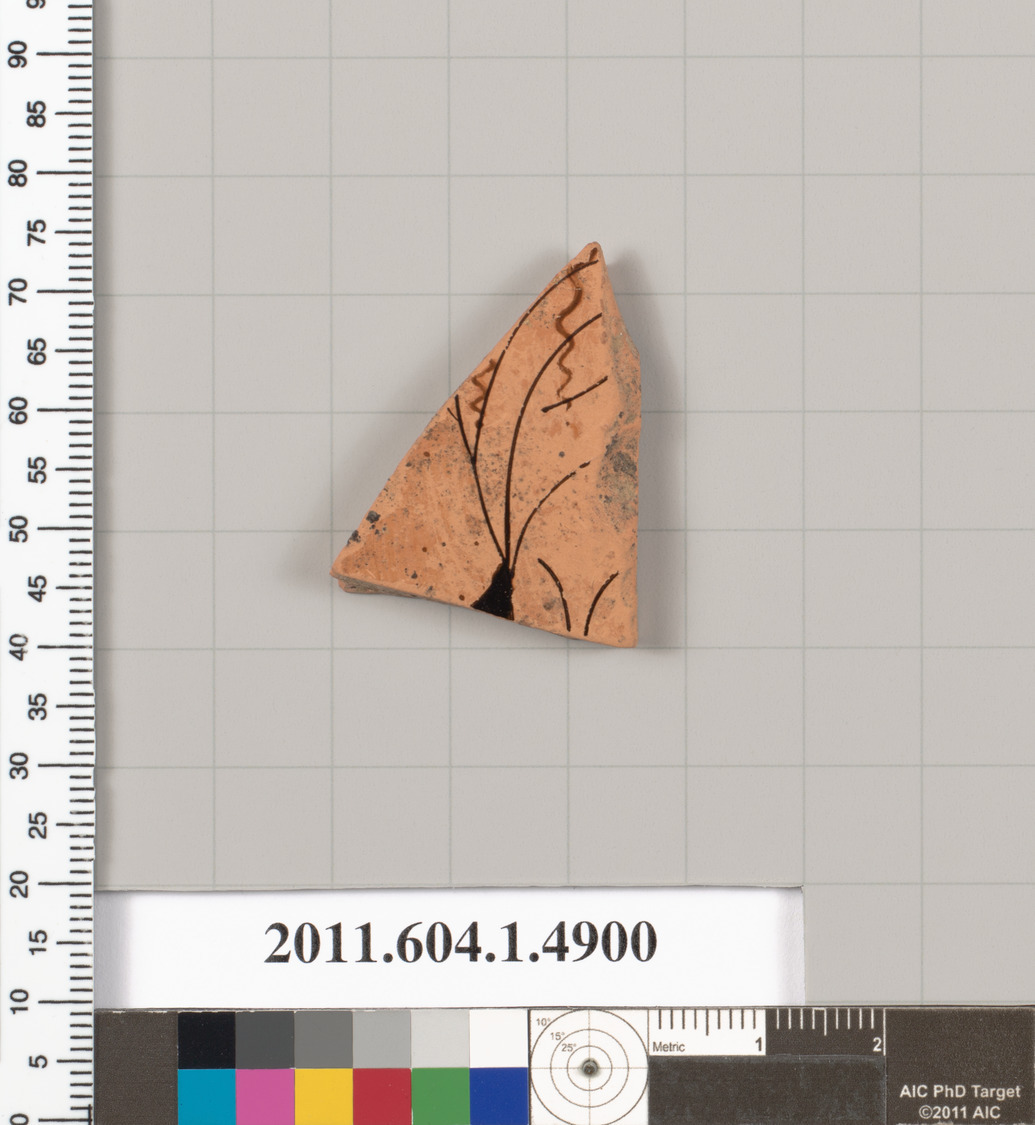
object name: kylix fragment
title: Terracotta fragment of a kylix (drinking cup)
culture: greek, attic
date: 467-435 BCE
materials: terracotta